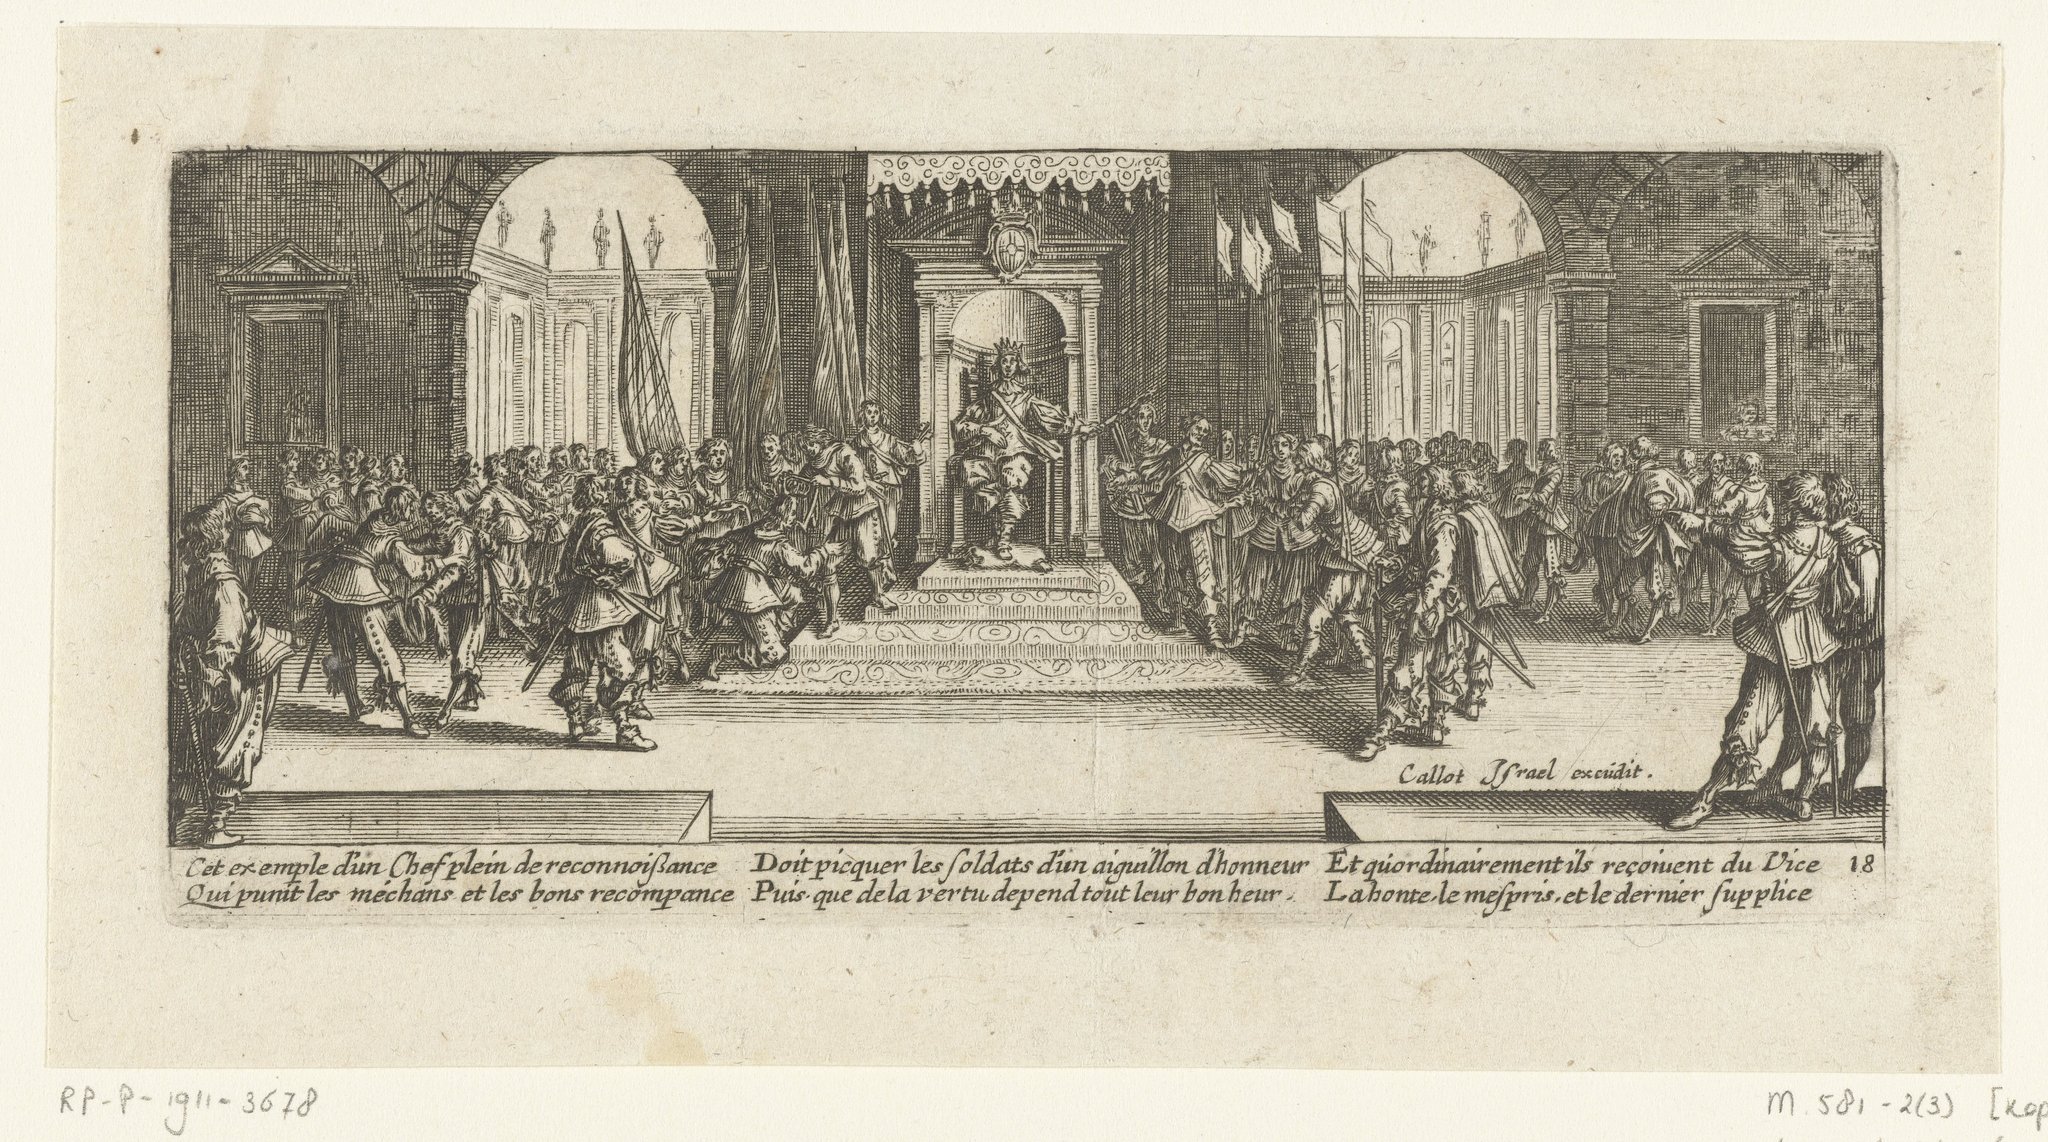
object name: print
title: De droeve ellendigheden van de Oorloogh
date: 1677-1690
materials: paper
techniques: etching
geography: paris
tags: medals and other marks of military honour, ruler giving mark of honour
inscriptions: collector's mark: Lugt 2228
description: In het midden van de voorstelling zit een koning op een troon. Links en rechts van hem staan soldaten. Een van hen knielt terwijl hem een ereteken wordt omgehangen. Onder de voorstelling een zesregelig Frans vers. Deze prent is onderdeel van een serie van 17 (18 incl. titelprent) prenten met voorstellingen van diverse soorten ellende die oorlogvoering met zich meebrengt.